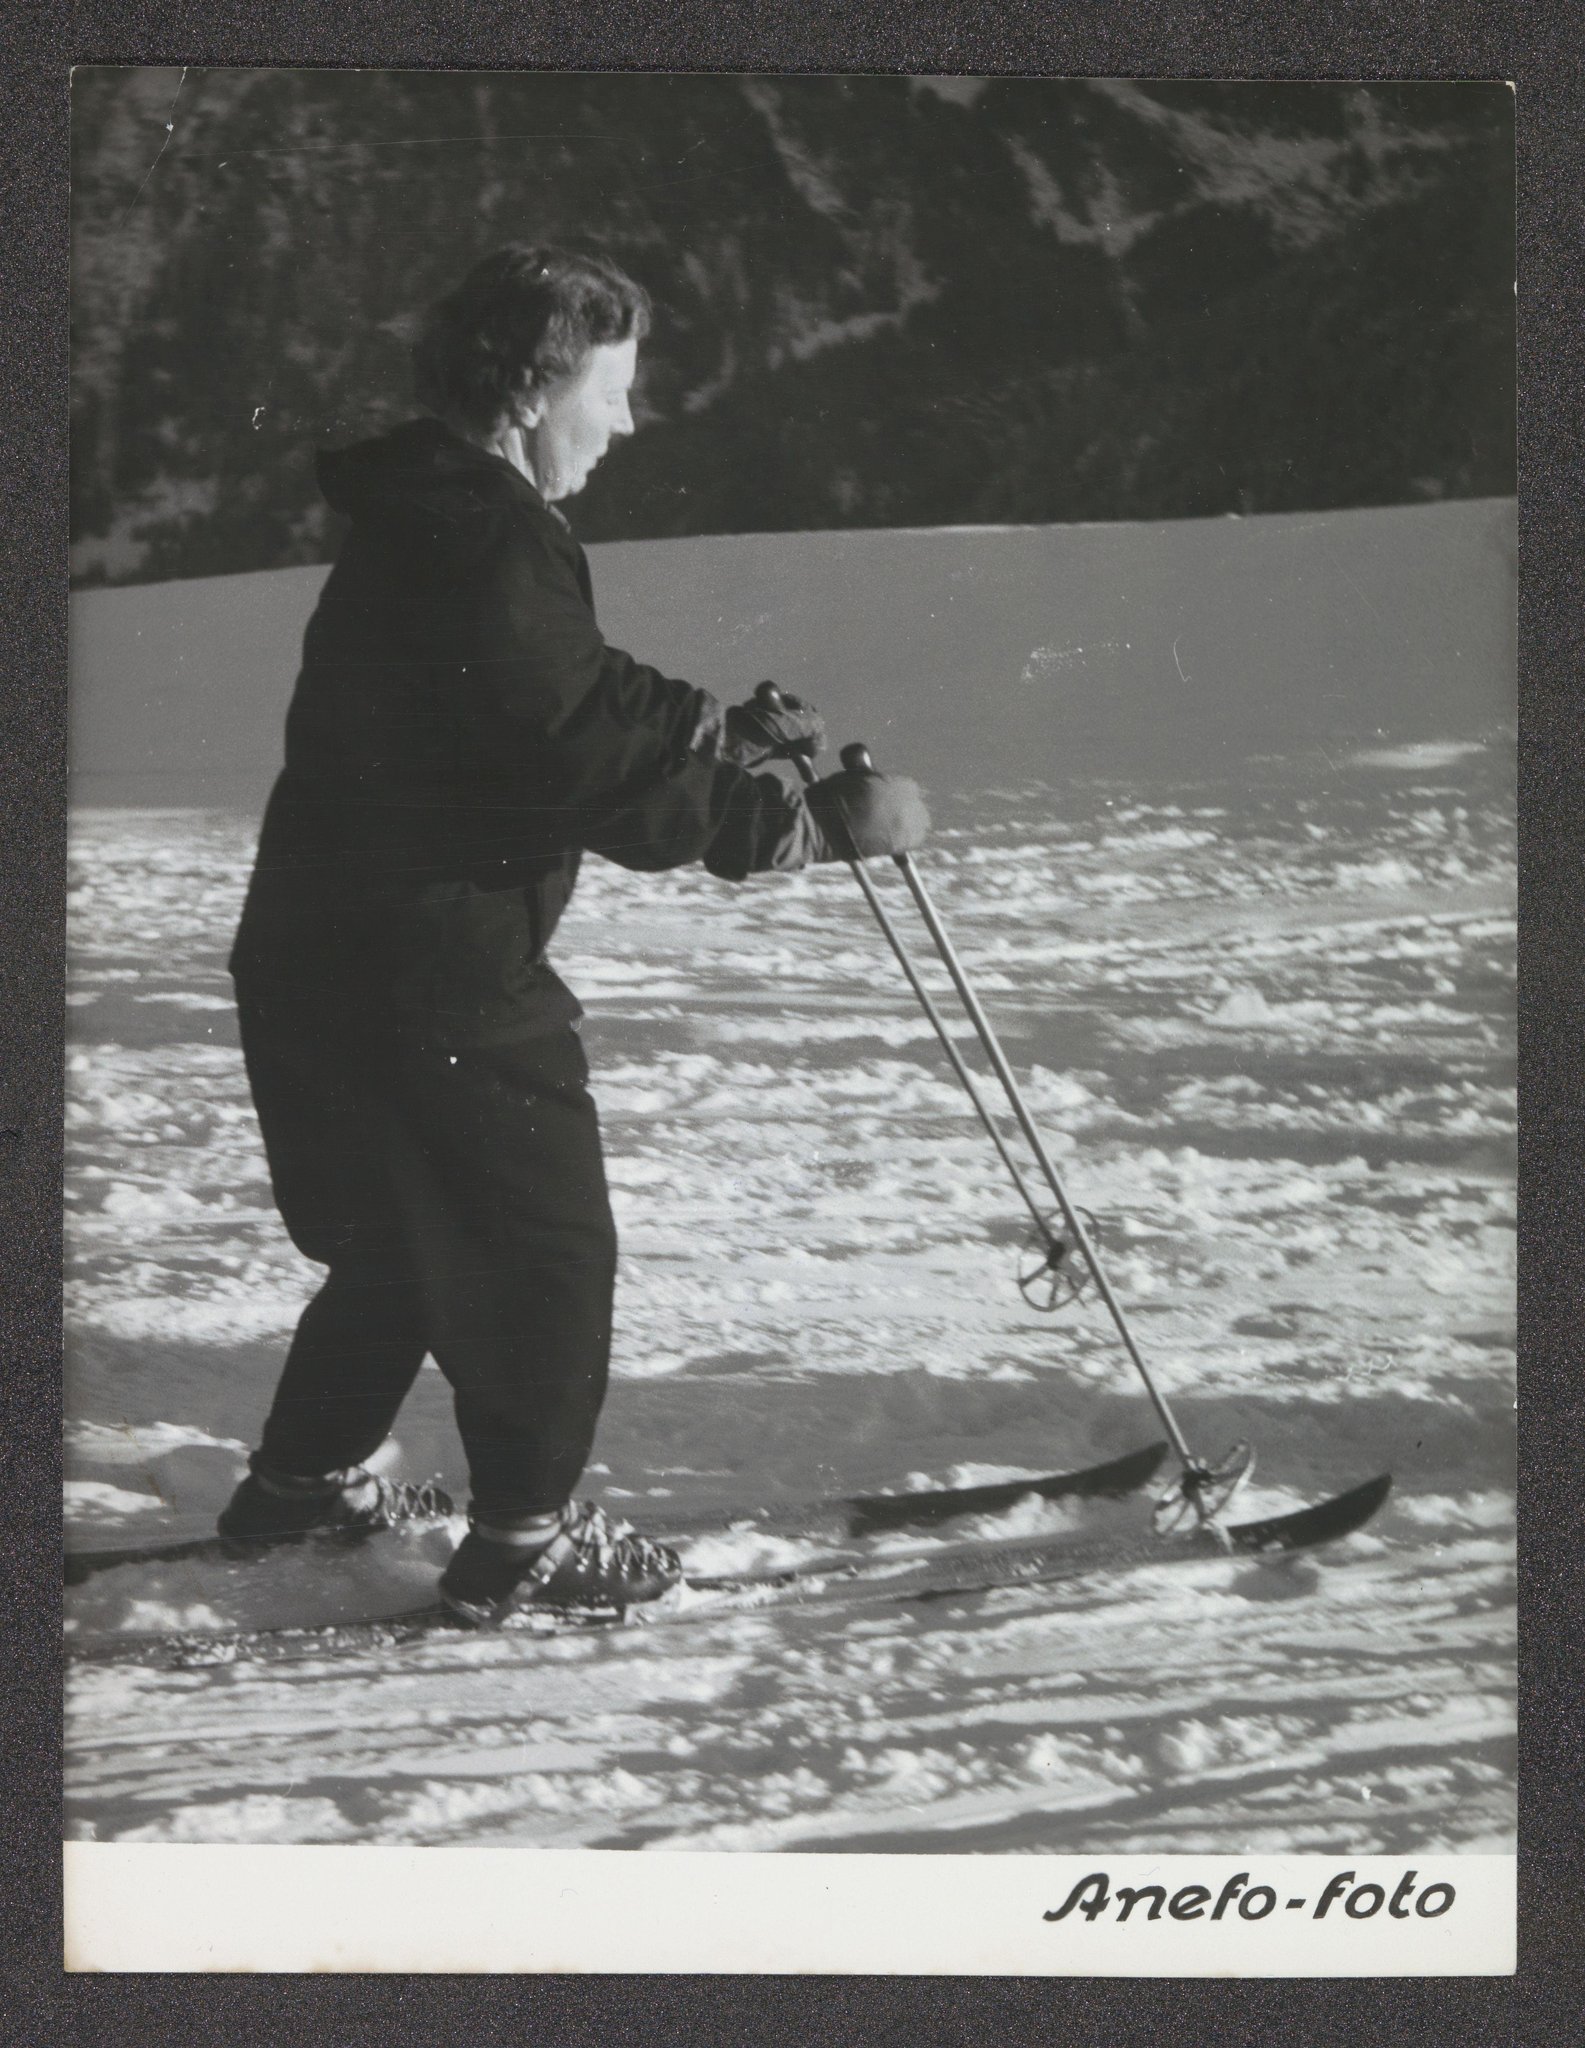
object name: photograph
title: Het Koninklijk gezin naar de wintersport in St. Anton. H.M. de Koningin tijdens het skien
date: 1955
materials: cardboard, paper, photographic support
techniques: gelatin silver print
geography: netherlands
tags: the hague, juliana of the netherlands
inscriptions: annotation: ‘Het Koninklijk gezin naar de wintersport in St. Anton H.M. de Koningin tijdens het skien’